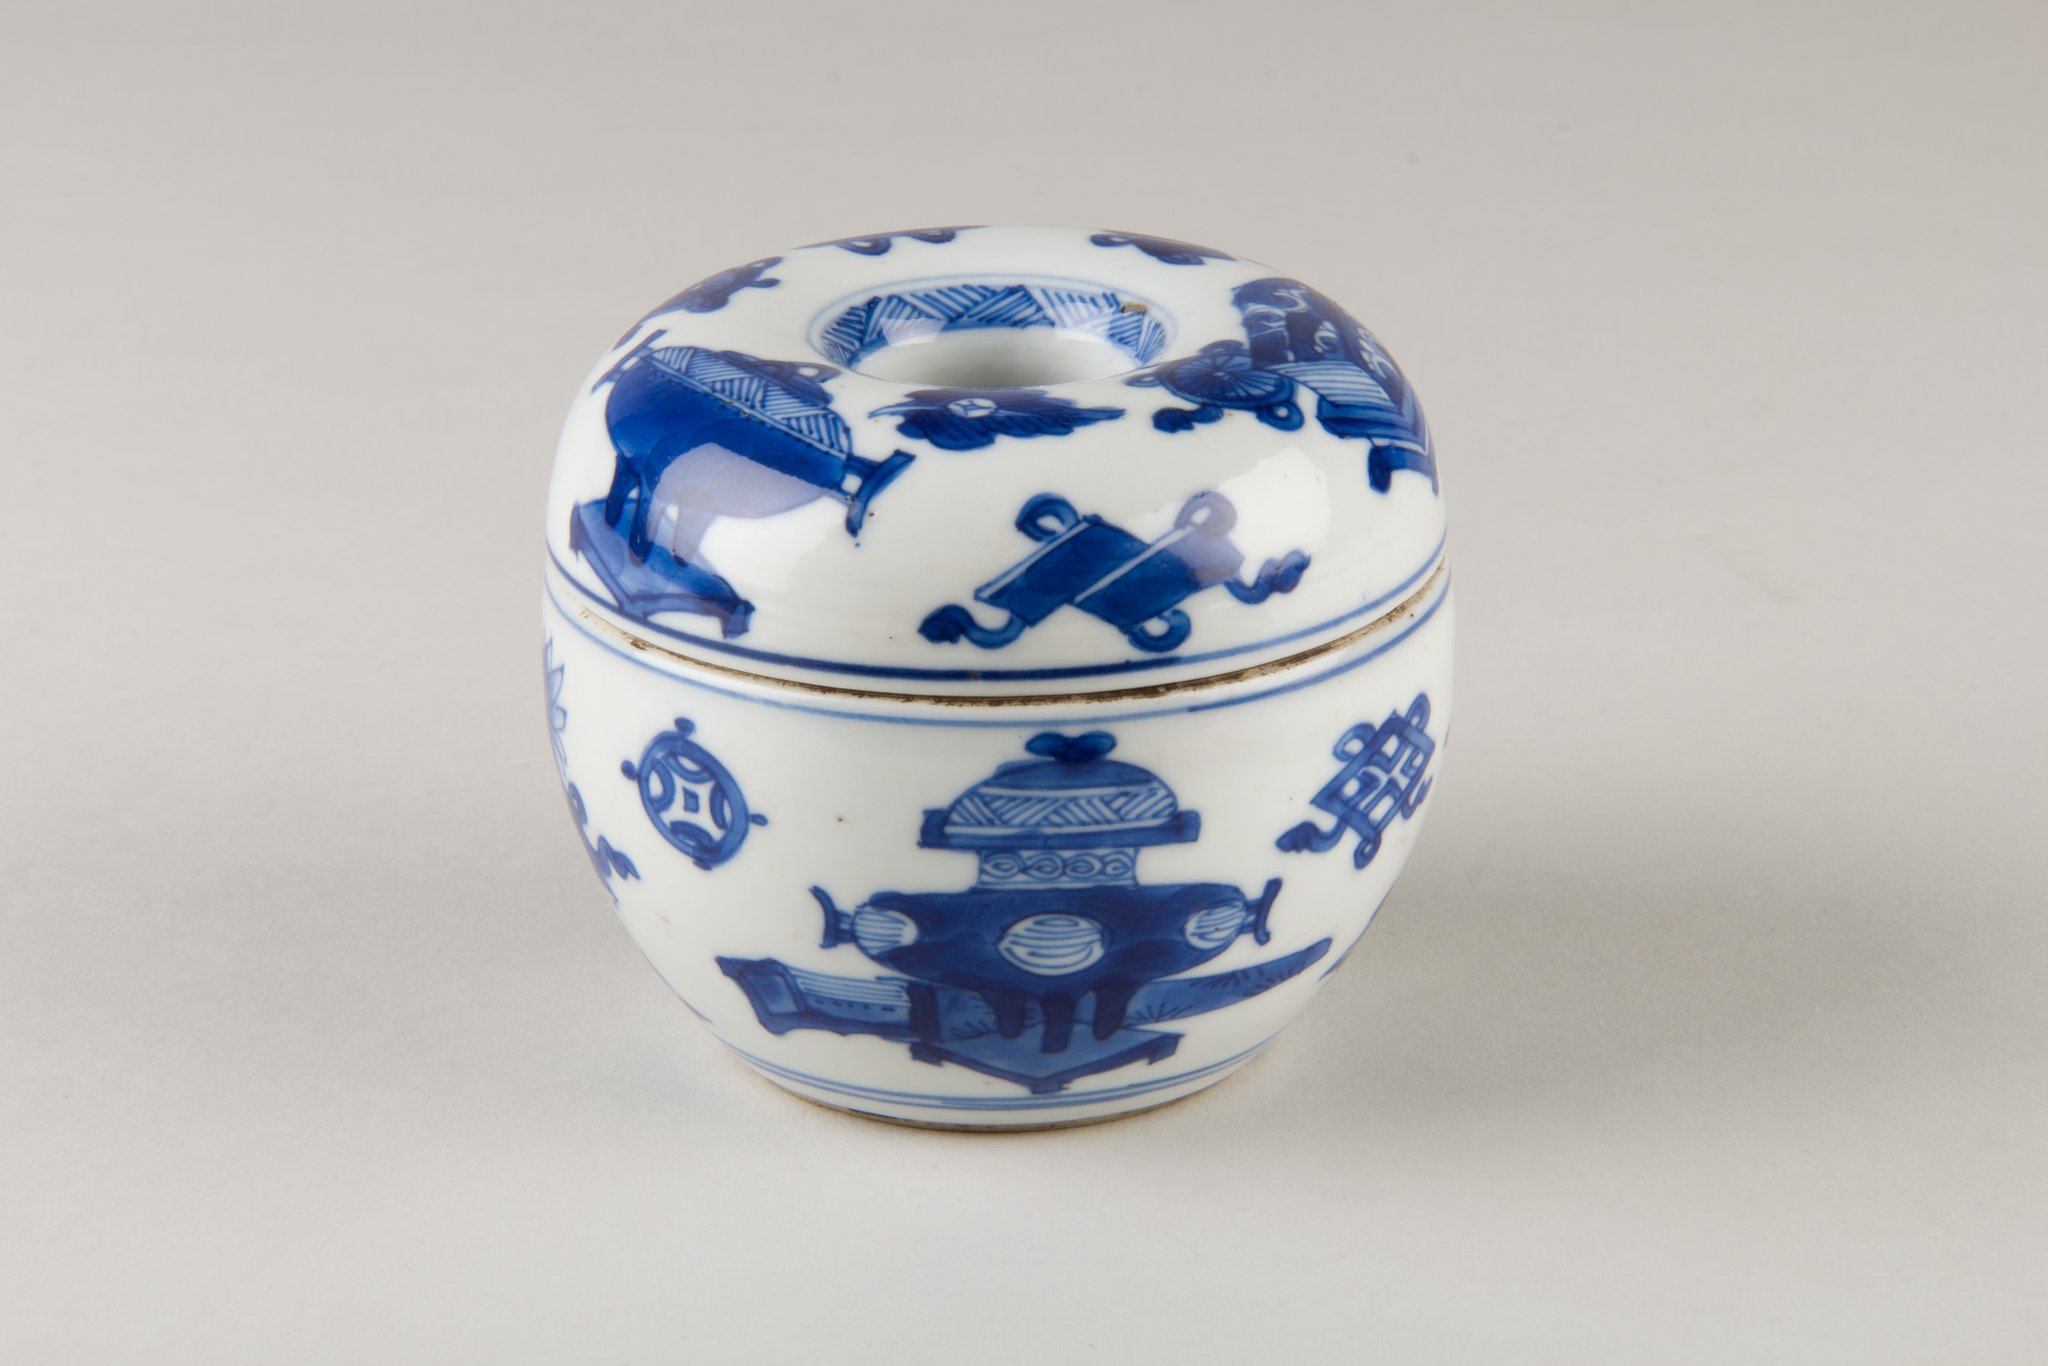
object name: covered box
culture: chinese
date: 1662-1722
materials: porcelain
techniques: underglaze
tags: flowers,leaves